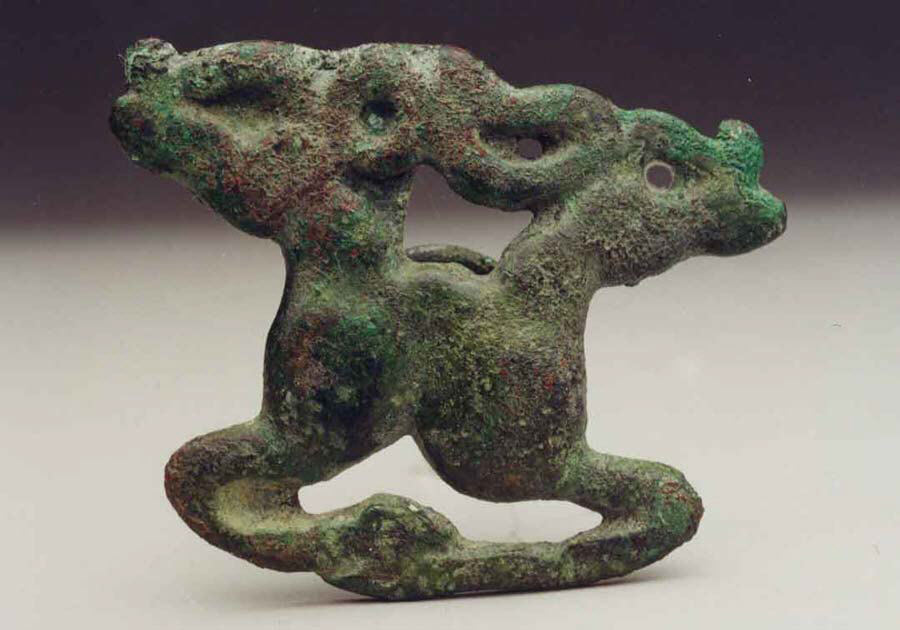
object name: garment plaque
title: Garment Plaque in the Shape of Deer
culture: kazakh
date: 600-301 BCE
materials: bronze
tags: deer